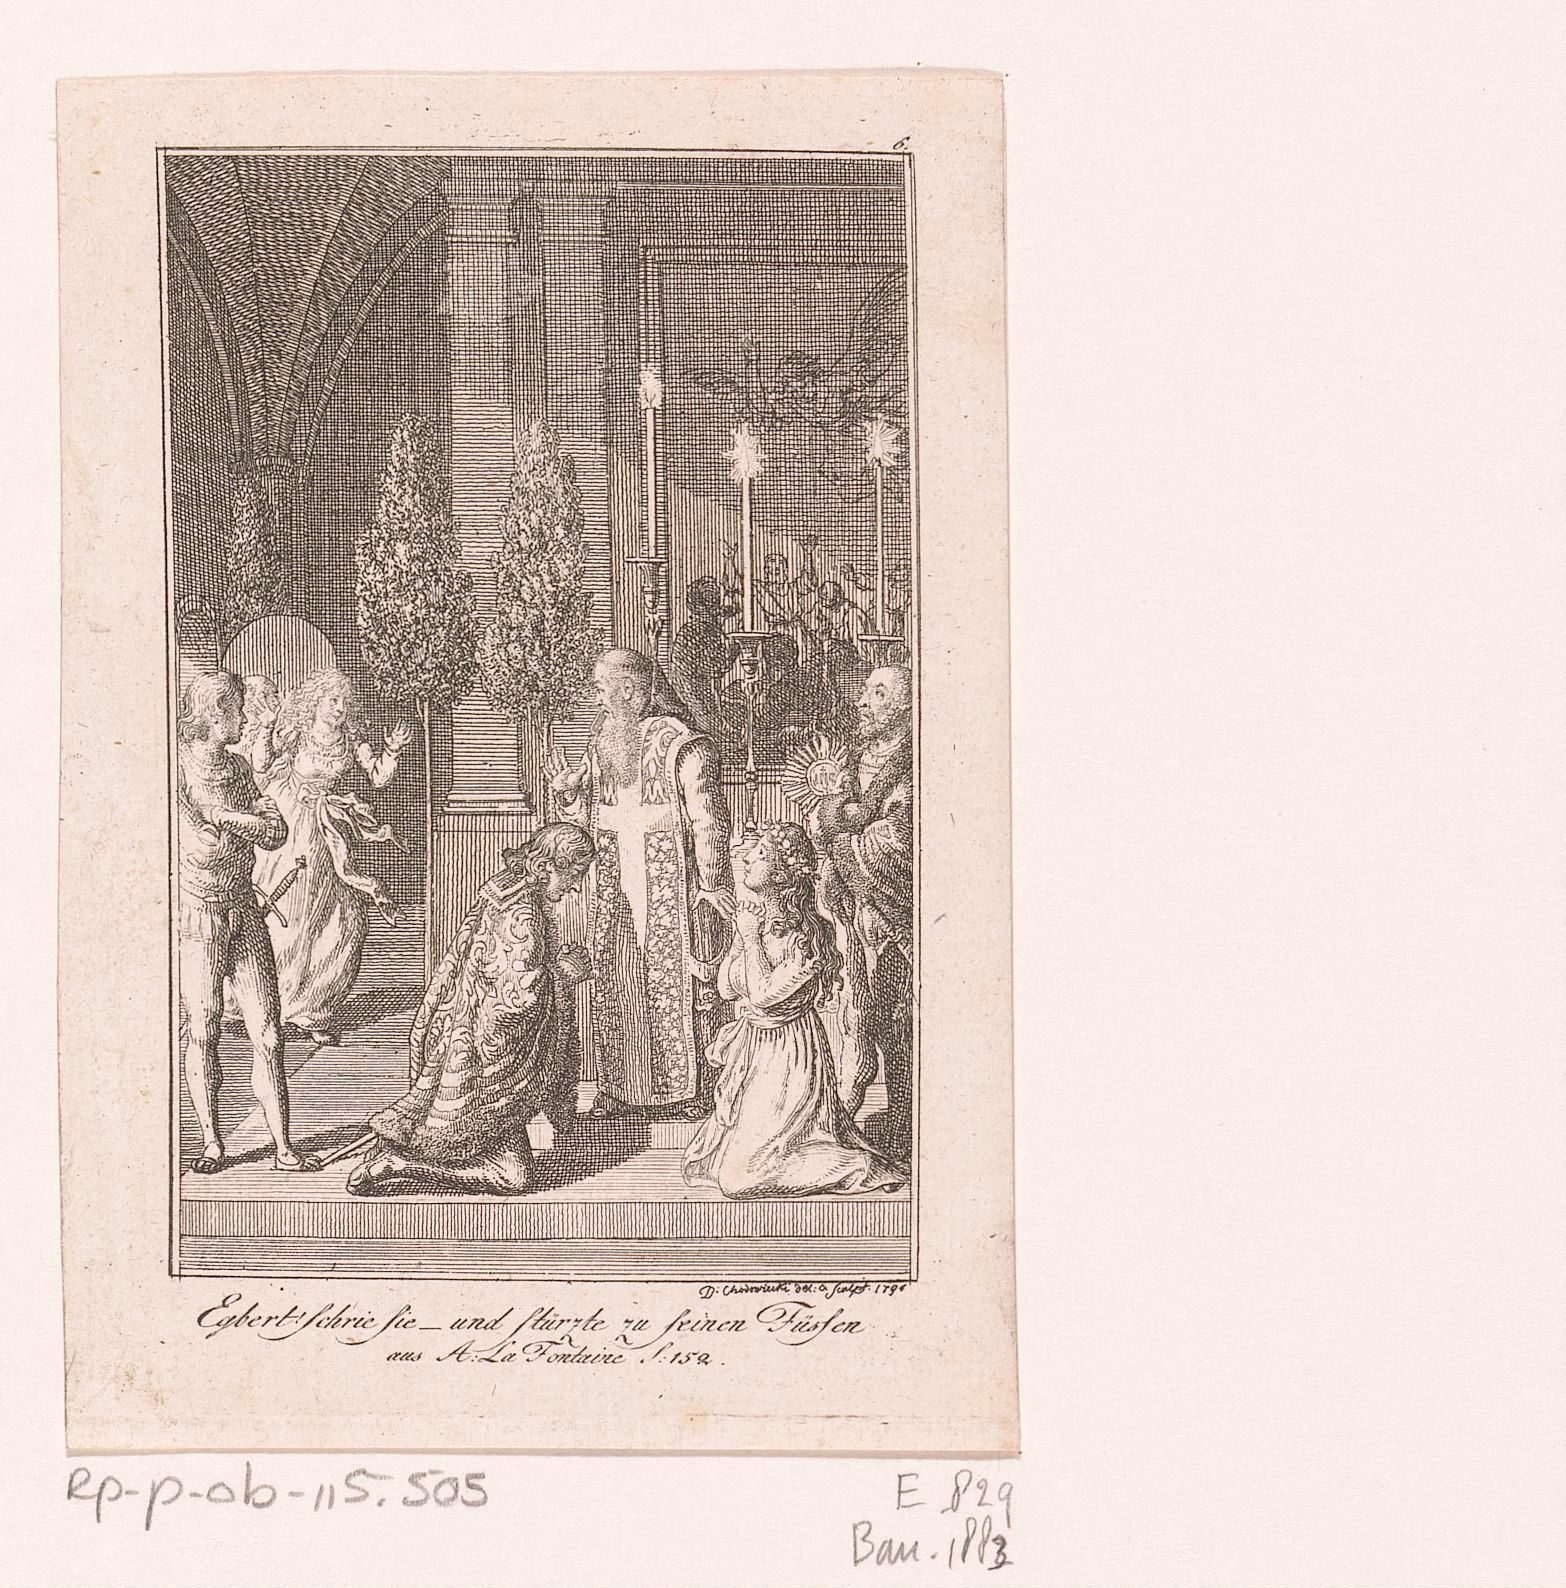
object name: print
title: Agnes onderbreekt de huwelijksceremonie van Bertha en Egbert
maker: daniel nikolaus chodowiecki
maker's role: draughtsman, print maker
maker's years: 1726-1801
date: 1796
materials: paper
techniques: etching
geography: berlin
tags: literature, (civil) marriage ceremonies, kneeling figure, interrupted meeting, lovers caught by surprise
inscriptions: collector's mark: Lugt 2228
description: Latere staat gebruikt voor: Becker, Wilhelm Gottlieb. Taschenbuch und Almanach zum geselligen Vergnügen, von W. G. Becker für 1797. Leipzig: Voss und Comp., [1796].